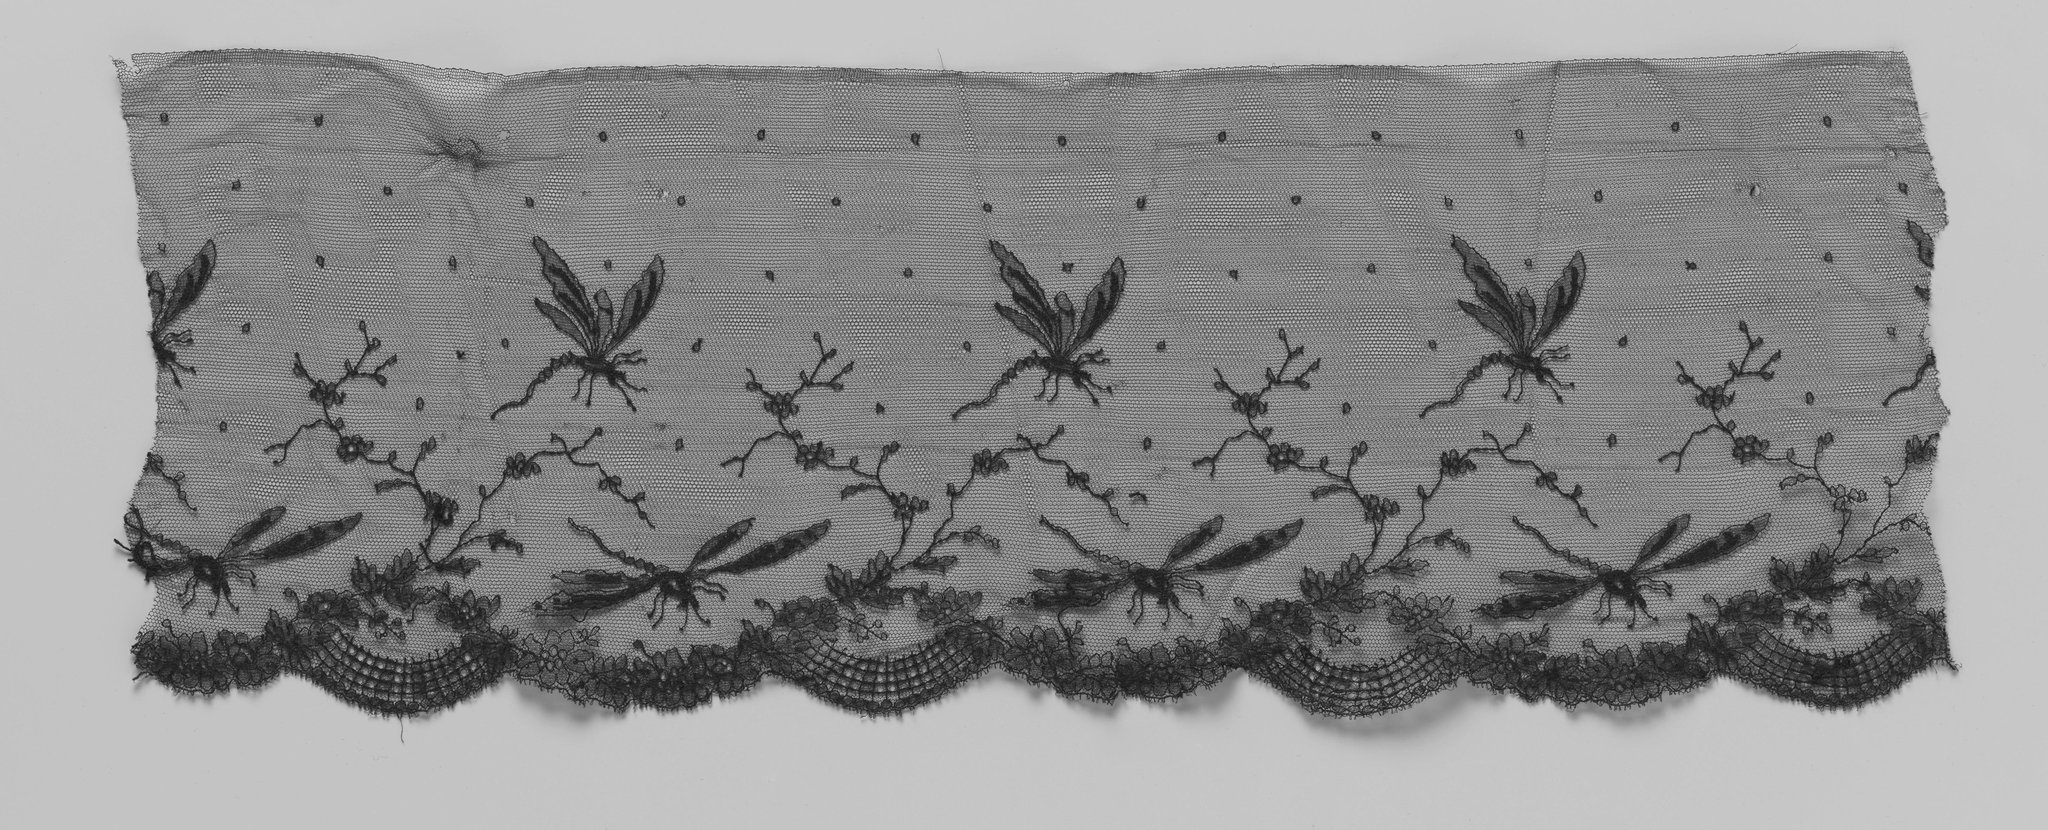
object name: strip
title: Strook zwarte machinale kant met libellen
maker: Anonymous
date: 1890-1899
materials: cotton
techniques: lace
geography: calais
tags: insects: dragon-fly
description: Strook zwarte machinale kant: machinale Chantilly-kant. Het zich herhalende patroon bestaat uit twee, bijna recht boven elkaar geplaatste, vliegende libellen. De vleugels van de bovenste libelle zijn meer omhoog gericht en die van de onderste libelle zijwaarts. Een ijle, gespleten rozentak met enkele bloempjes en blaadjes ontspringt onderaan de strook aan een golvende lijn, die bestaat uit een aaneenschakeling van rozentakjes. Onder elke golftop hangt een gebogen korte sierband met een vierkant raster. De motieven zijn voorzien van contourdraden en zijn met elkaar verbonden door een machinale tulegrond, die is bezaaid met moesjes. Als siergrond is onder andere een machinale rozengrond toegepast in de gebogen sierband en in de bloemharten. De gebogen sierband vormt onder de toppen van de doorgaande golvende rozentakjes de schulpenrand, die is afgewerkt met picots. De bovenzijde van de strook is recht afgewerkt.